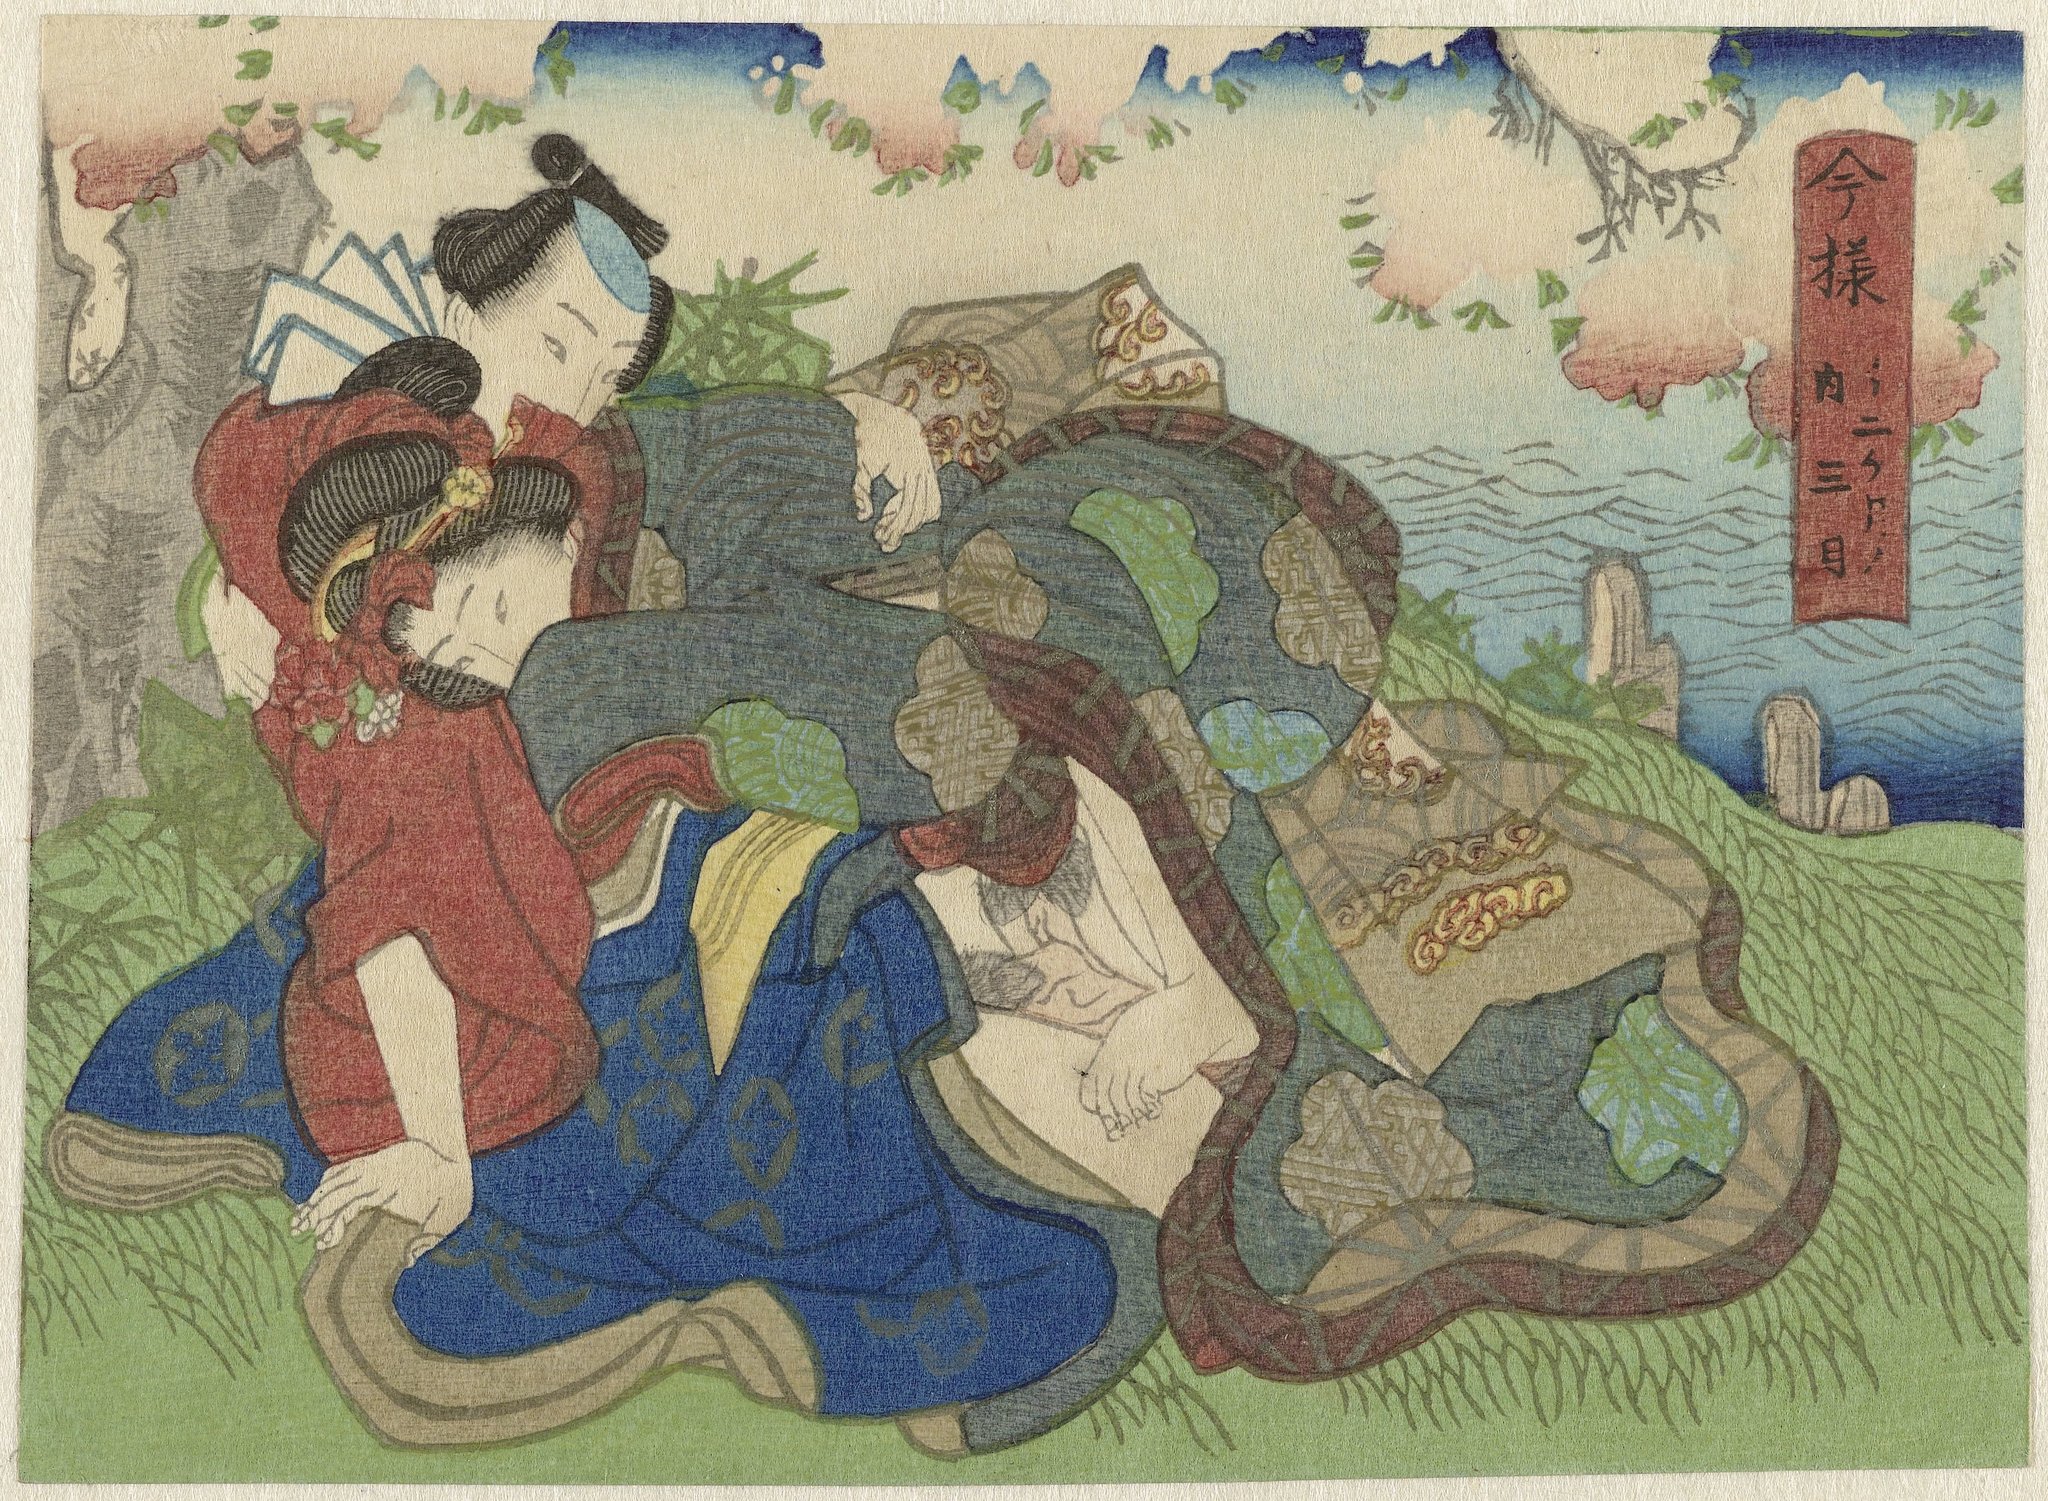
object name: shunga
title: Imayô jûni kagetsu no uchi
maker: Anonymous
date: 1835-1845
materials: paper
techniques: woodcut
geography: japan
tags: the twelve months of the year represented by concepts other than personifications, human activities, landscapes, or still lifes of flowers and/or fruits, coitus, cohabiting, sexual intercourse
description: Onder een bloeiende kersenboom, met een rivier op de achtergrond, heeft een vrouw een zittende man bestegen. De welvende en opbollende kimono's laten een opening waardoor de penetratie zichtbaar is.